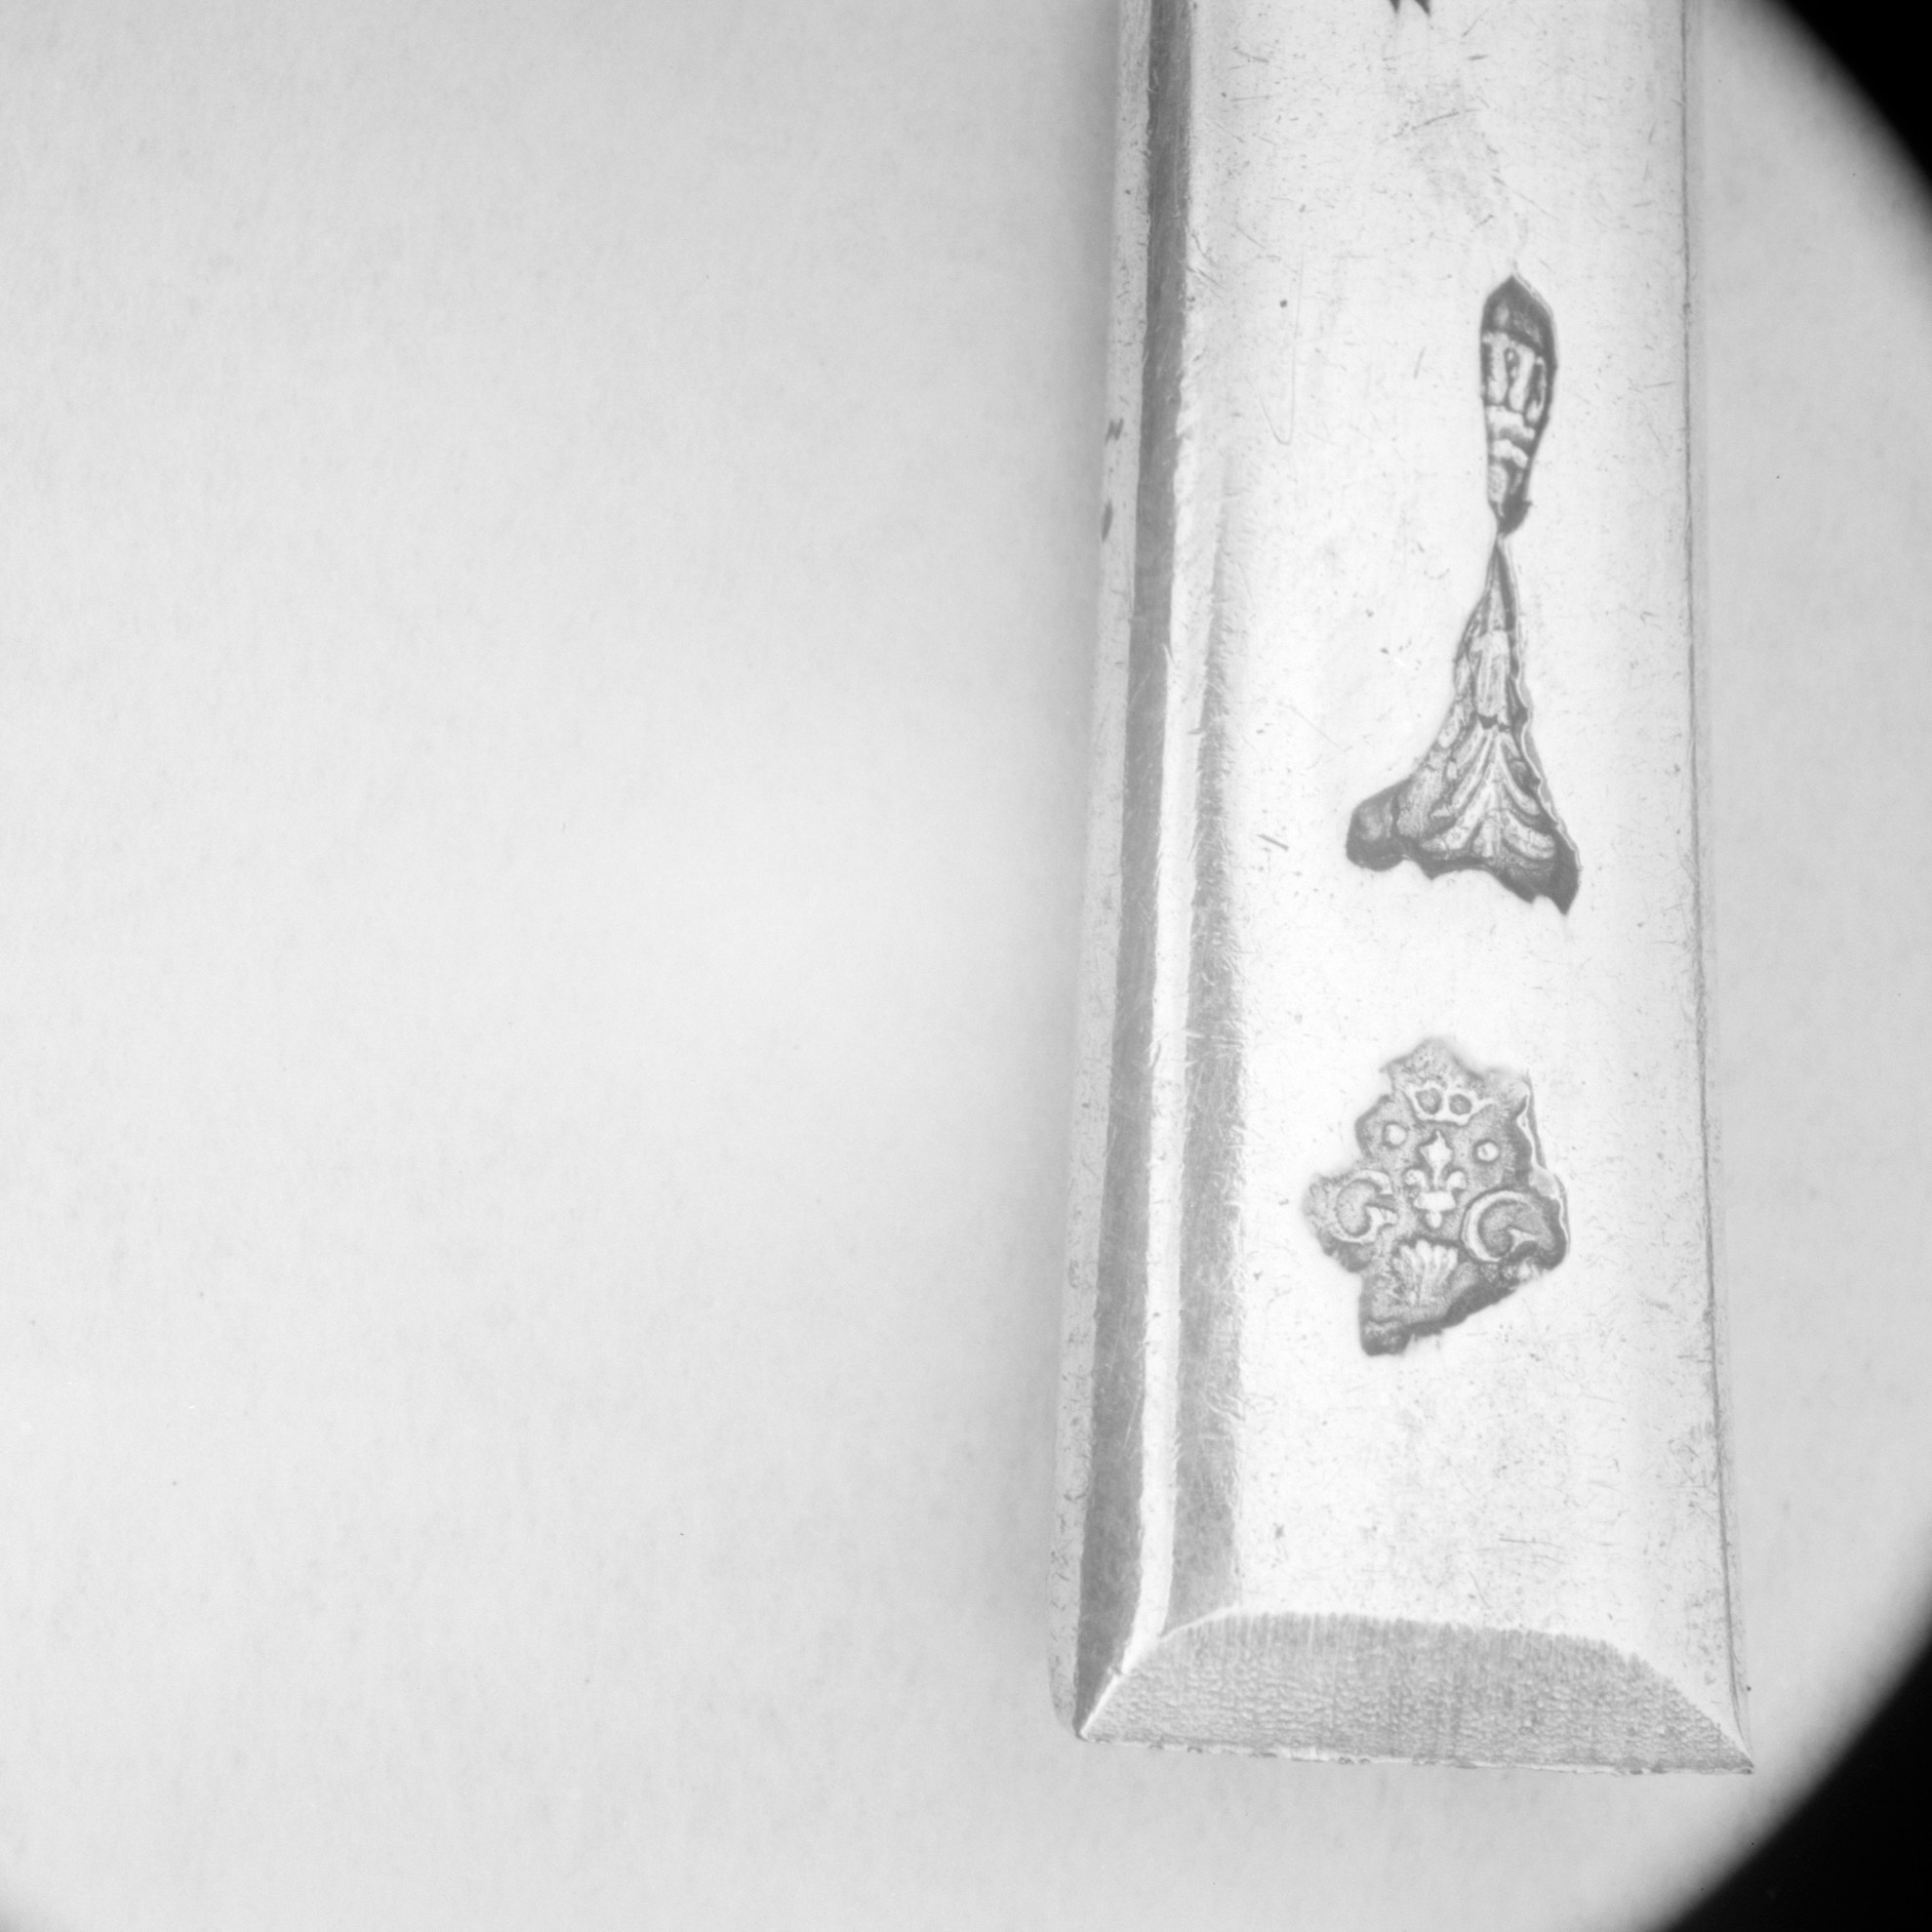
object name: spoon handle section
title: Section of a spoon handle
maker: gabriel gerbu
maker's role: maker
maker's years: 1752-1836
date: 1788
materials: silver